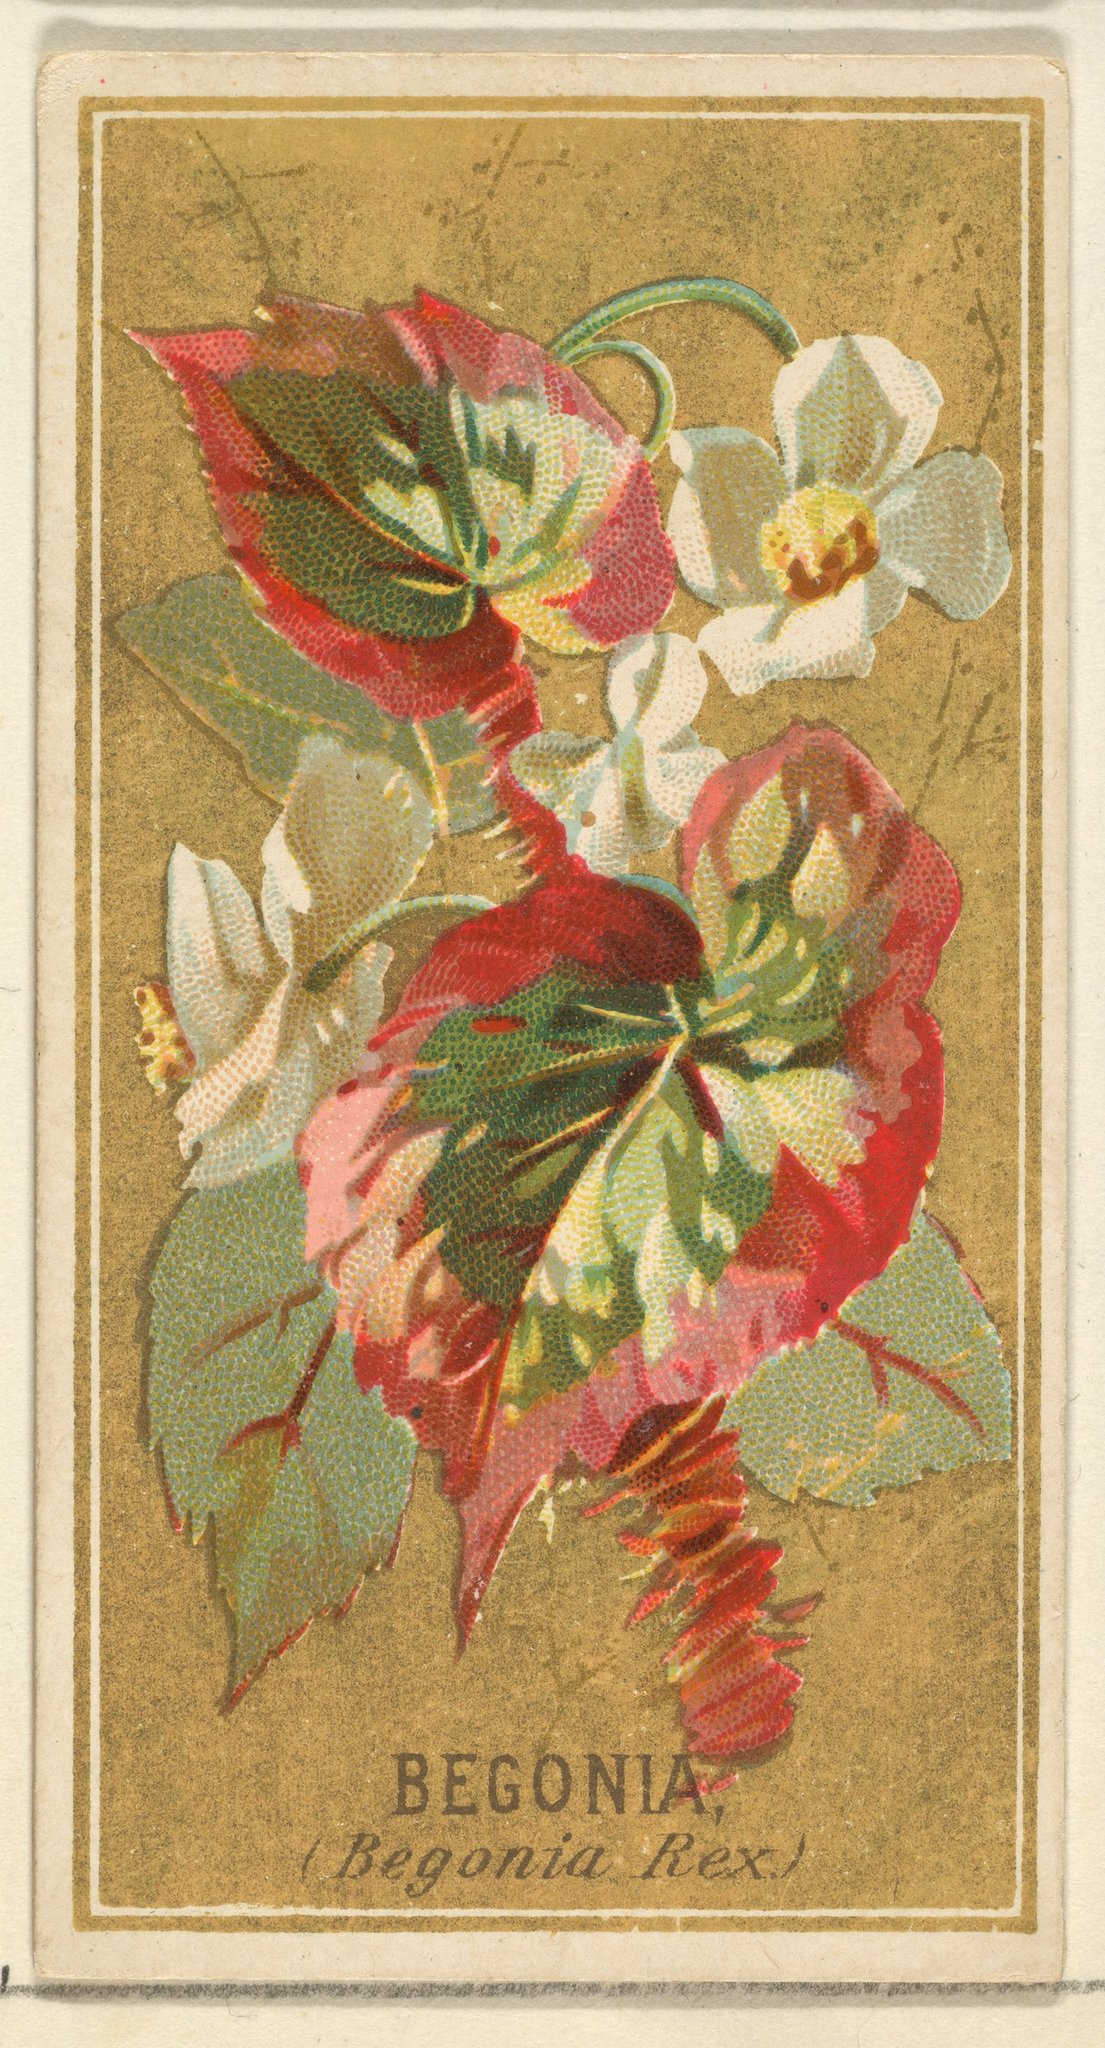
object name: print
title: Begonia (Begonia Rex), from the Flowers series for Old Judge Cigarettes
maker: goodwin & company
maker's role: publisher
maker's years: 1850-1950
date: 1890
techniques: color lithograph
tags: flowers,leaves